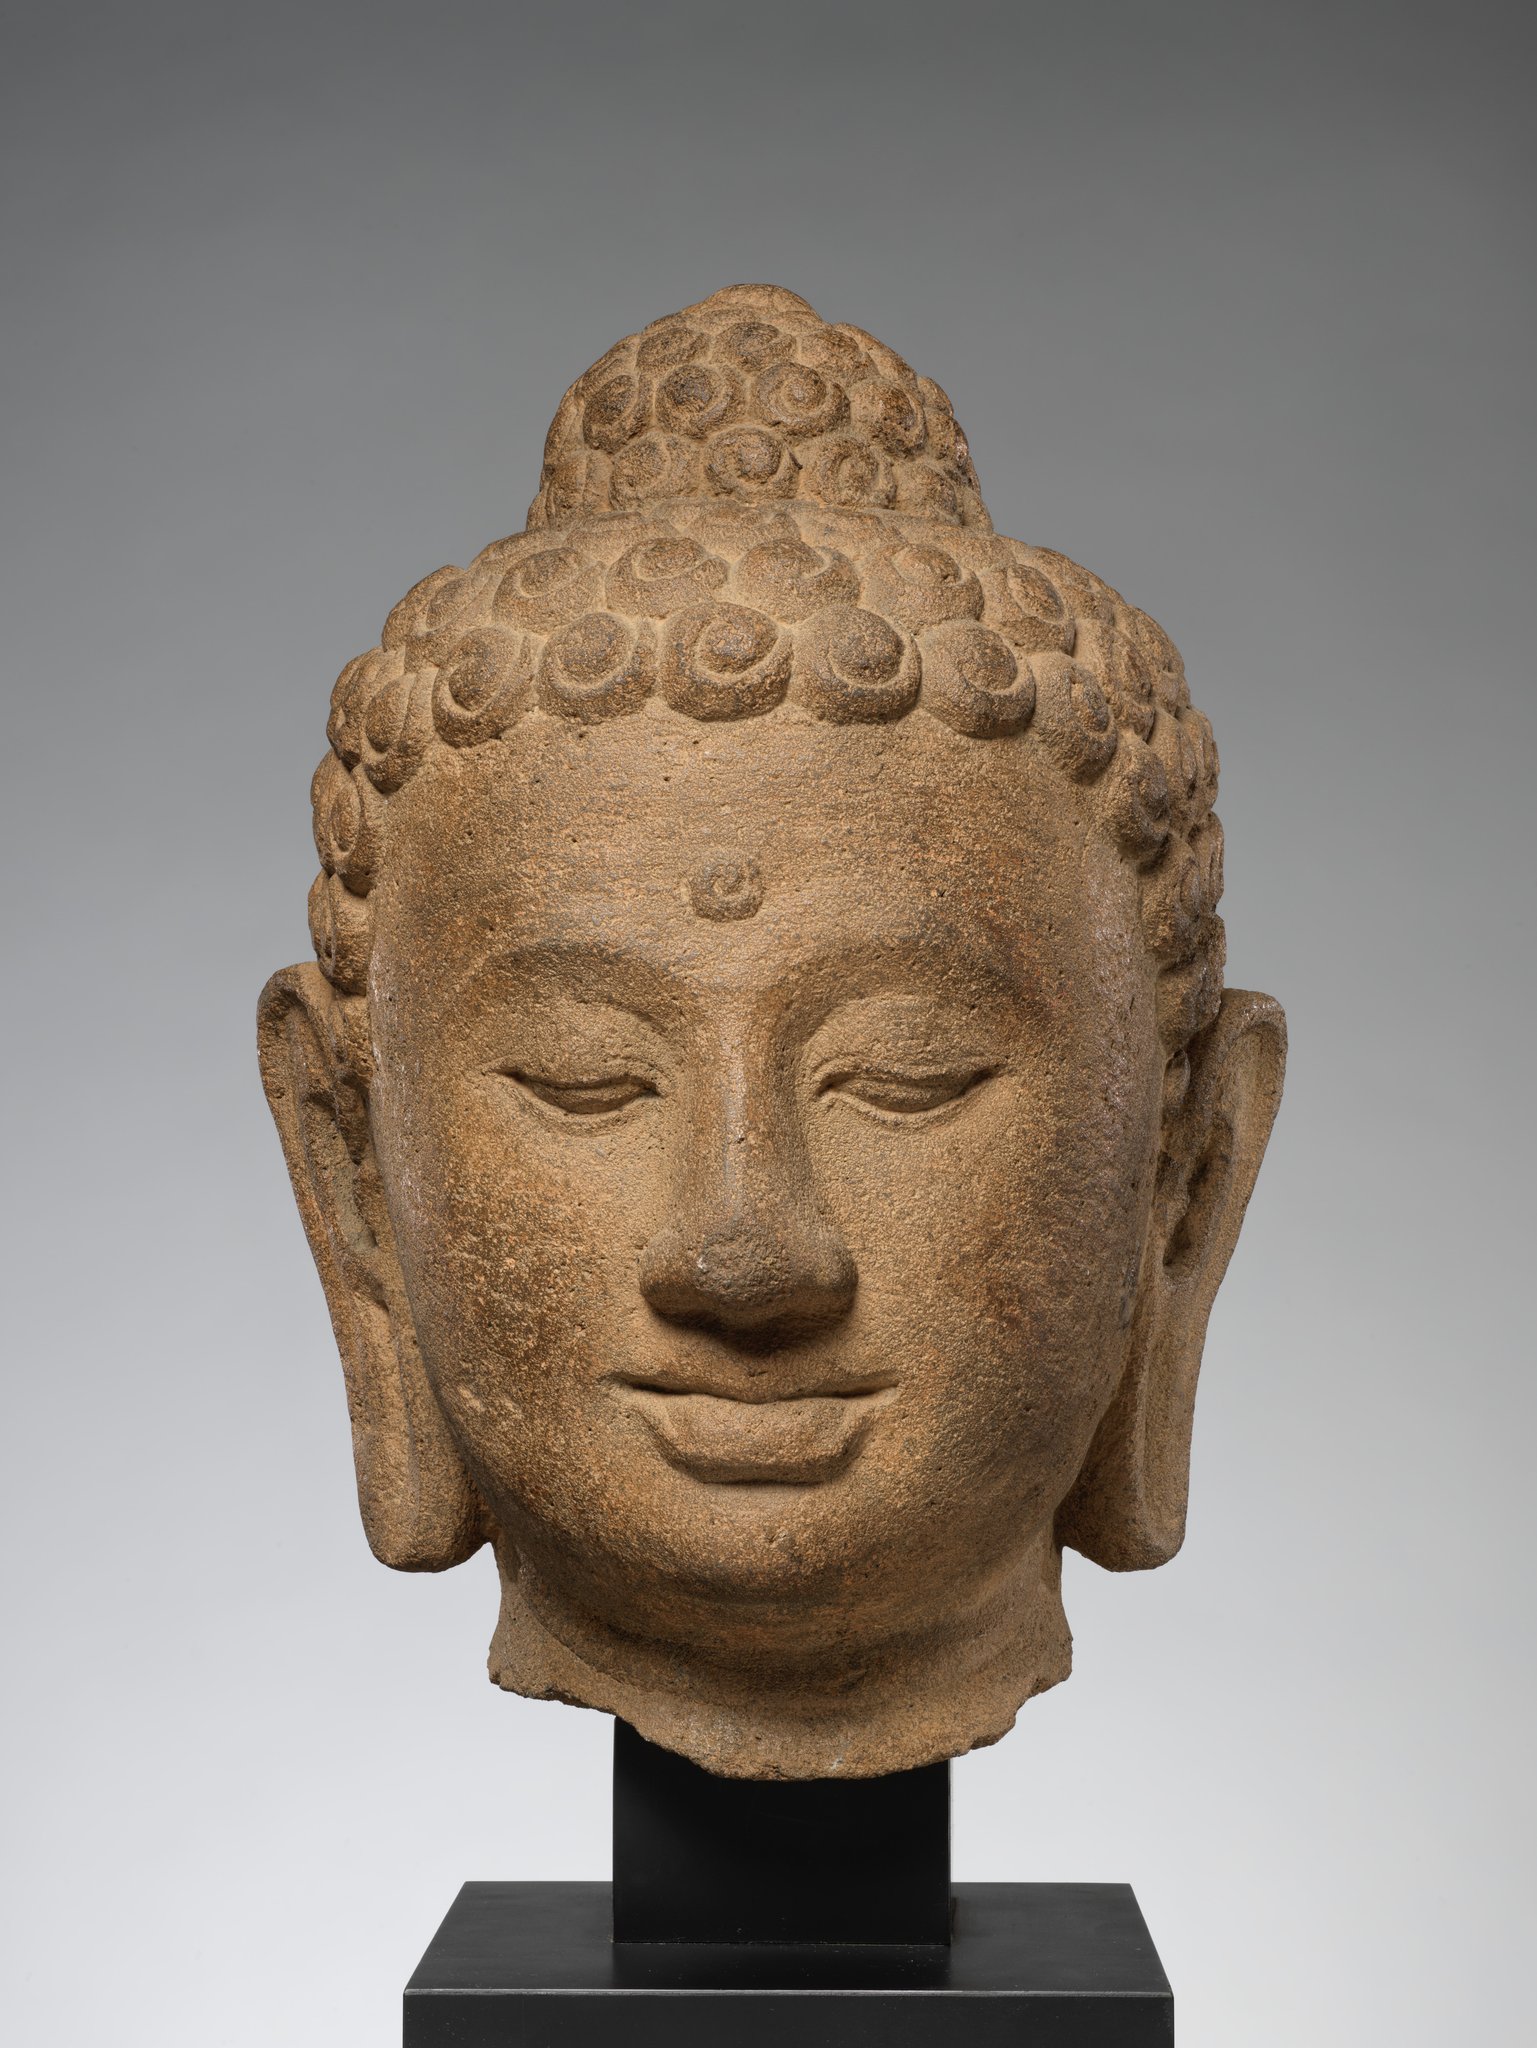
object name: head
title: Head of a Buddha (Study Collection)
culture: indonesian, javanese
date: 1901-2000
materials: stone